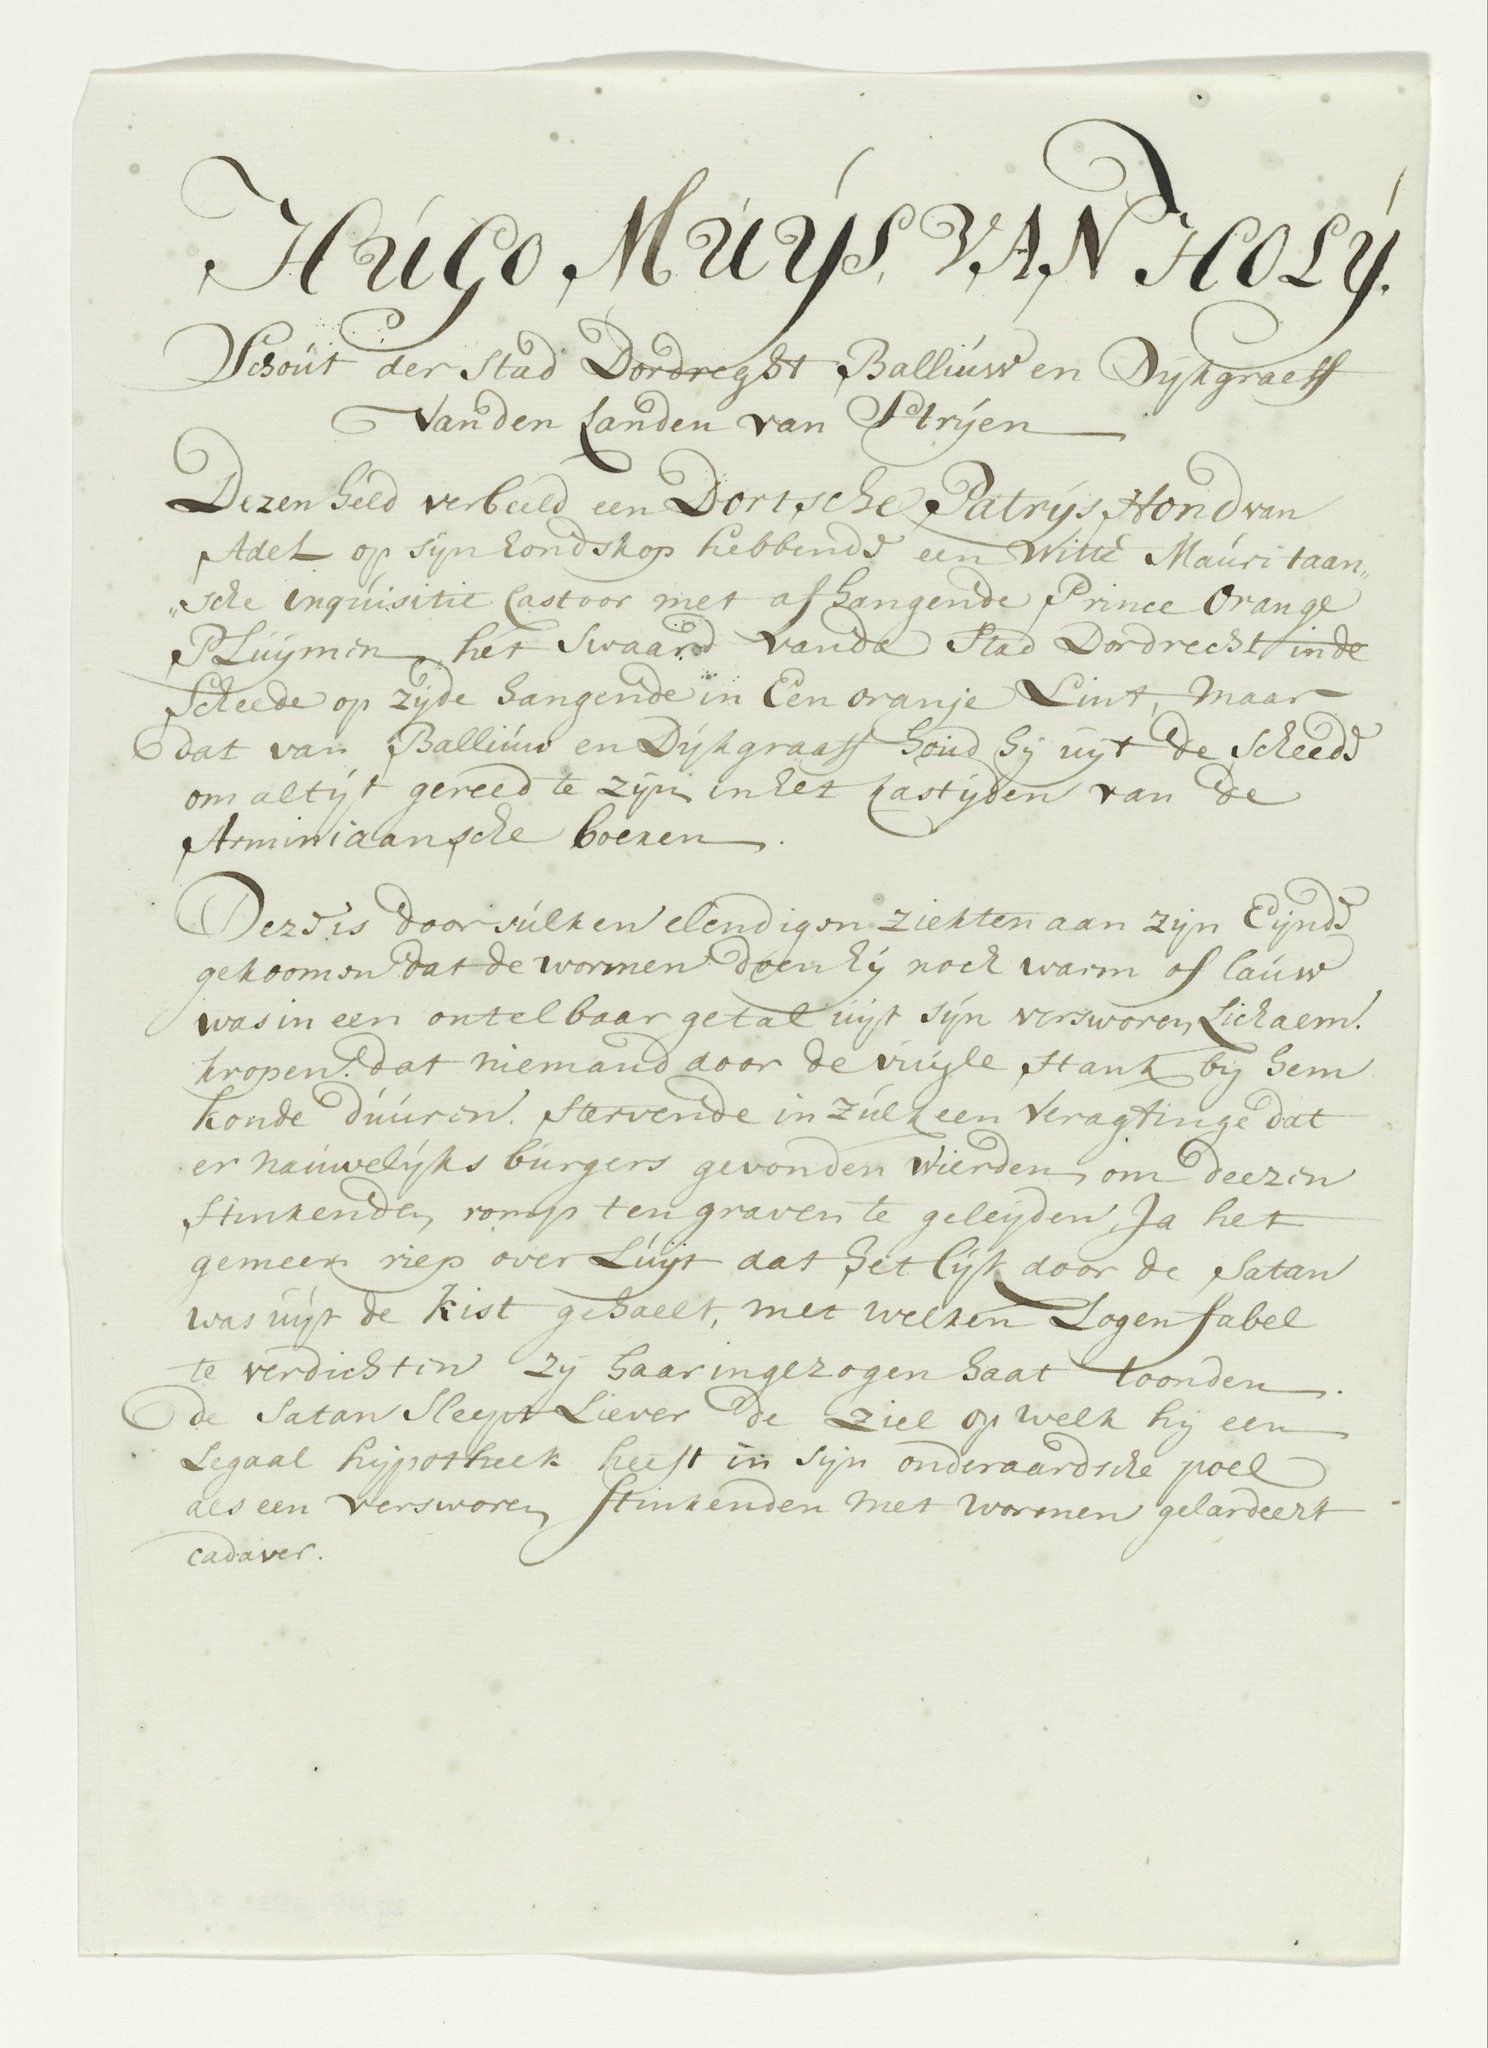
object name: poem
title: Spotvers bij het portret van Hugo Muys van Holy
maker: Anonymous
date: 1710-1720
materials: paper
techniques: pen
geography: netherlands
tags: johan van oldenbarnevelt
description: Spotprent van Hugo Muys van Holy, rechter van Van Oldenbarnevelt; hond met 2 zwaarden en witte hoed met oranje pluim in krans van bloemen en bladeren. Daaronder cartouche met aan weerszijden en boven putti. In cartouche naam en daaronder nr. 8. Behorende bij serie aquarellen in boek.